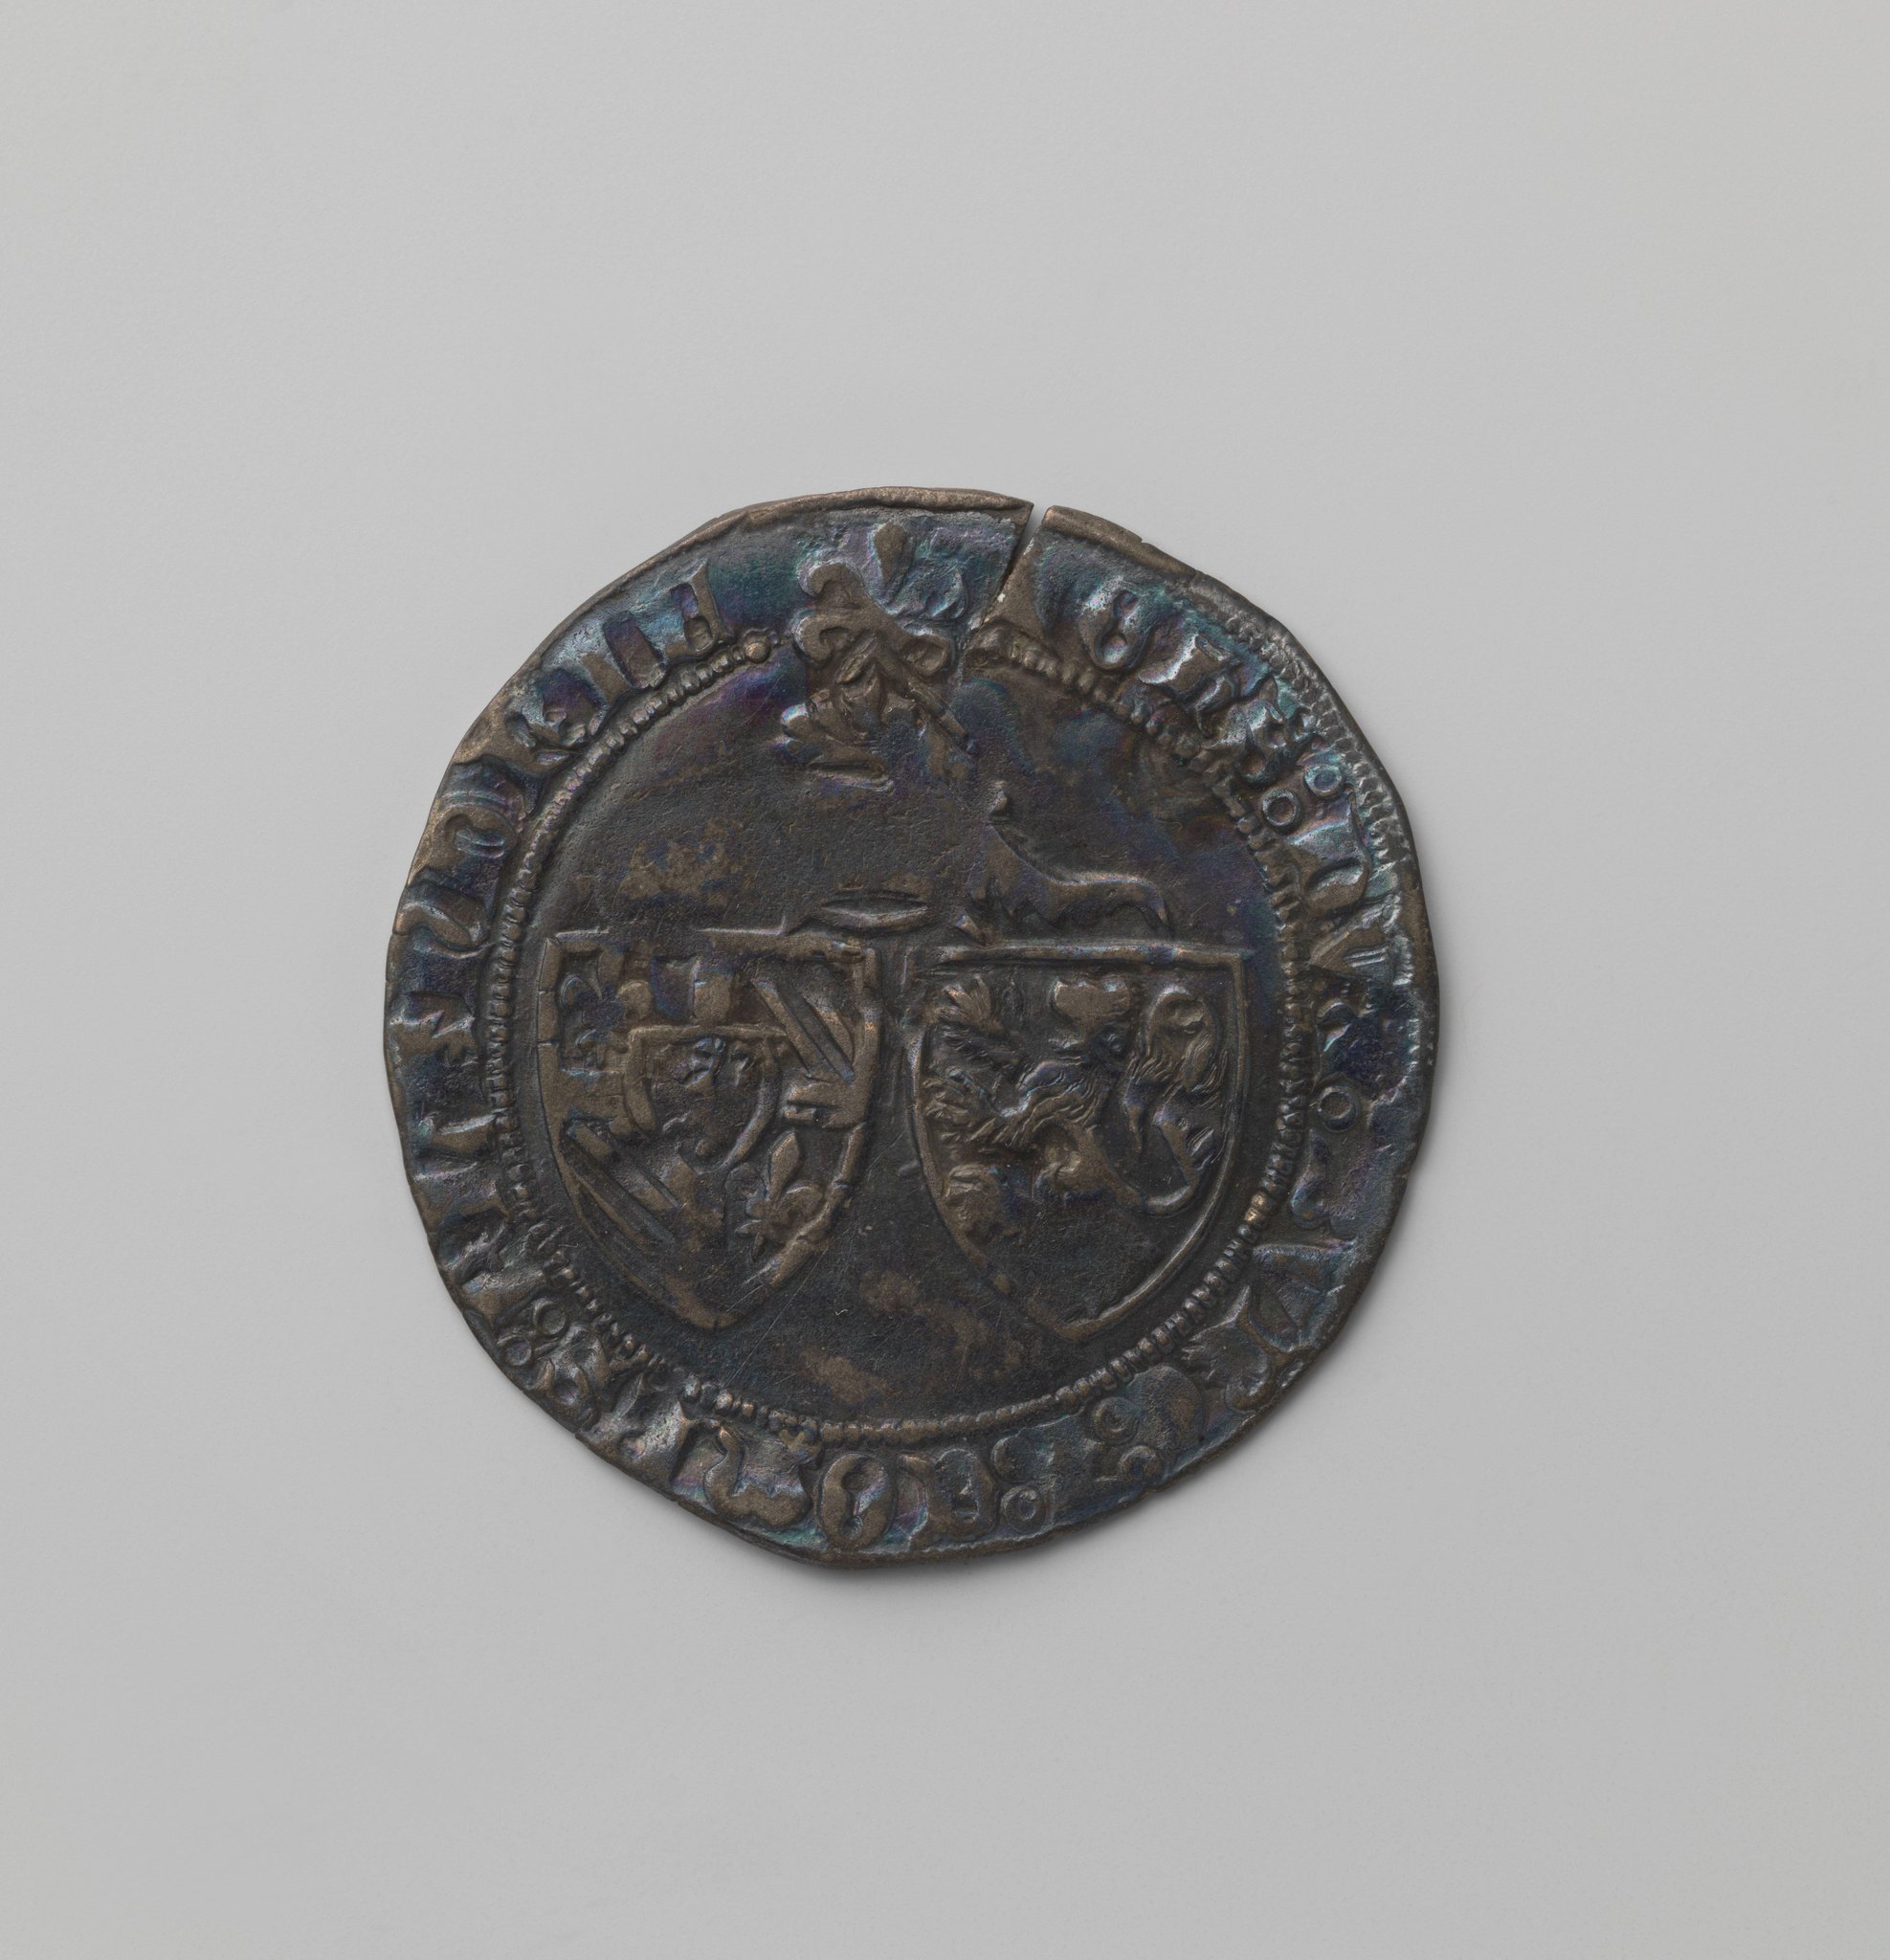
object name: coin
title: Dubbele groot (braspenning) uit Vlaanderen van Jan zonder Vrees, 1404-1419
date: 1404-1419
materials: silver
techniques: striking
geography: ghent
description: Voorzijde: onder helm met helmteken twee naast elkaar geplaatste wapenschilden. Keerzijde: kort gevoet kruis, in de hoeken afwisselend lelie en leeuw.